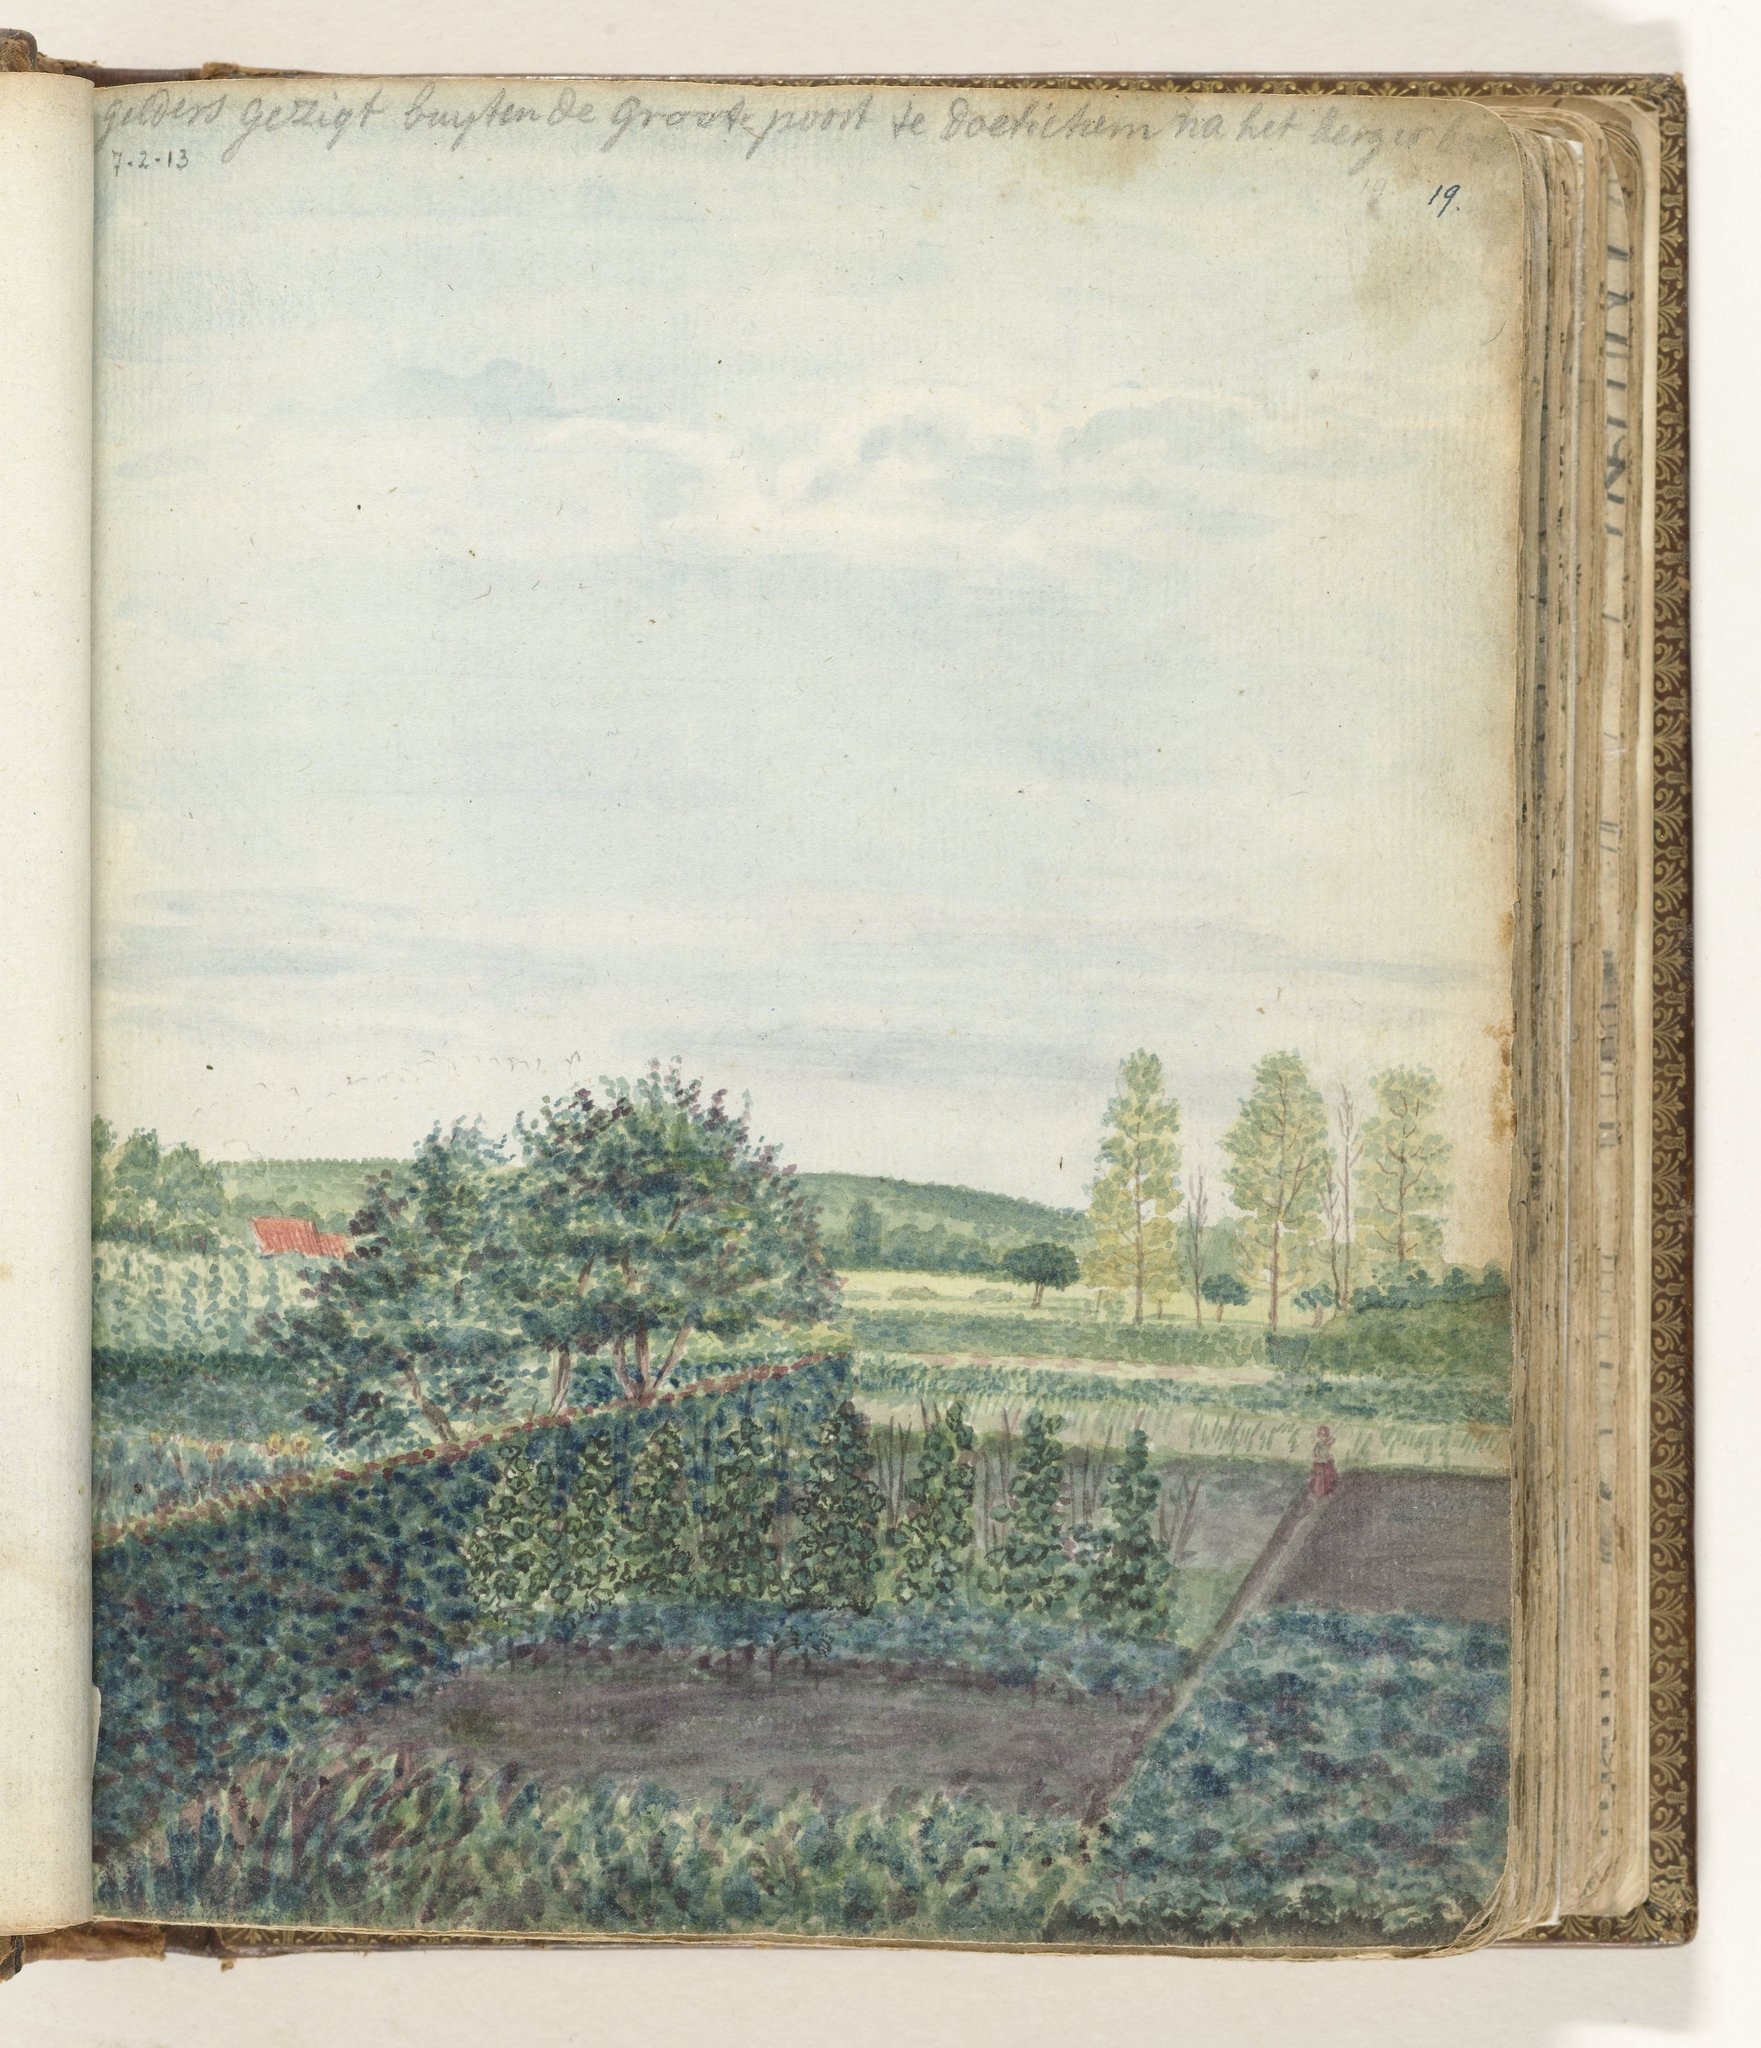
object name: drawing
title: Gelders gezicht bij Doetinchem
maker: jan brandes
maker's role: draughtsman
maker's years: 1743-1808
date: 1770-1778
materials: paper, pencil, watercolor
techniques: brush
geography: doetinchem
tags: cultivation of (ornamental) garden, horticulture, vegetable culture, market gardening, garden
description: Kleurtekening van licht glooiend landschap met een moestuin, landbouwgrond, in de verte een dak van een huis. Met opschrift. Onderdeel uit het schetsboek van Jan Brandes, dl. 2 (1808), p. 19.